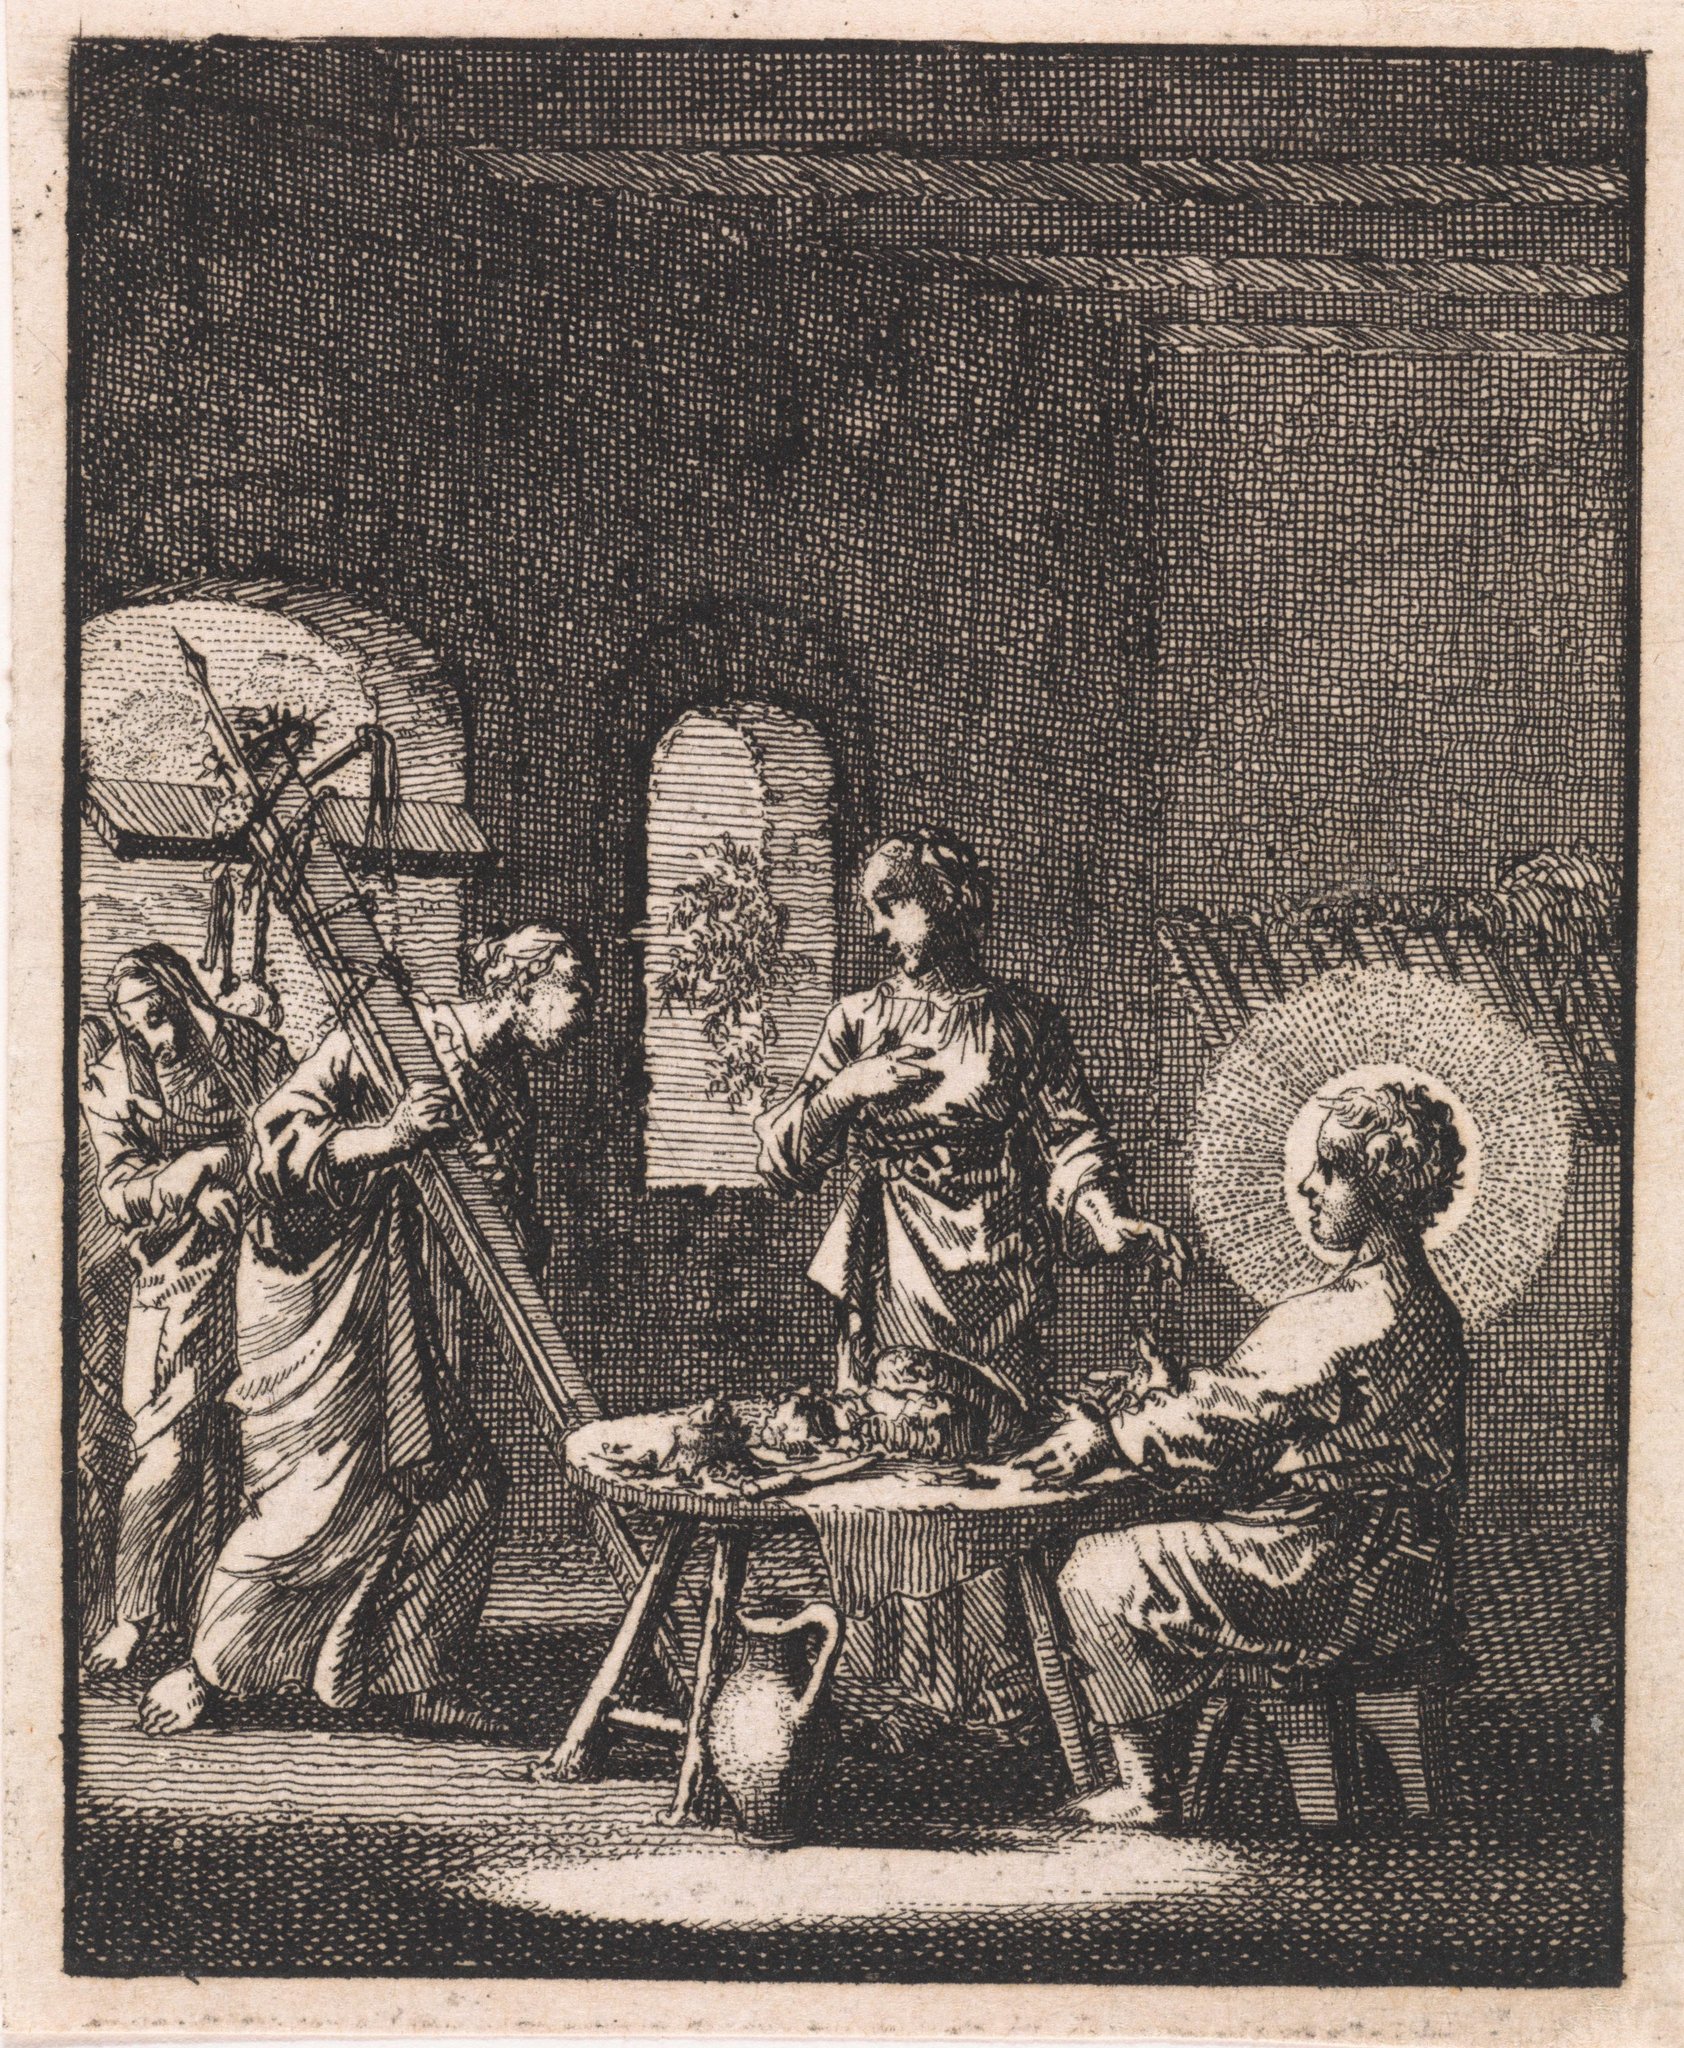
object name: print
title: Jezus in huis met de Ziel, aan welke het kruis wordt voorgehouden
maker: jan luyken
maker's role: draughtsman, print maker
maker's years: 1649-1712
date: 1714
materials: paper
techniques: etching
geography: amsterdam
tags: cross as symbol of christ, the soul, christ and the soul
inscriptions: collector's mark: Lugt 2228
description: Proefdruk van illustratie uit: Luyken, Jan. Jezus en de Ziel, 3 delen. Amsterdam: Wed. Pieter Arentsz II en Cornelis van der Sys, 1714, dl. III, p. 151.